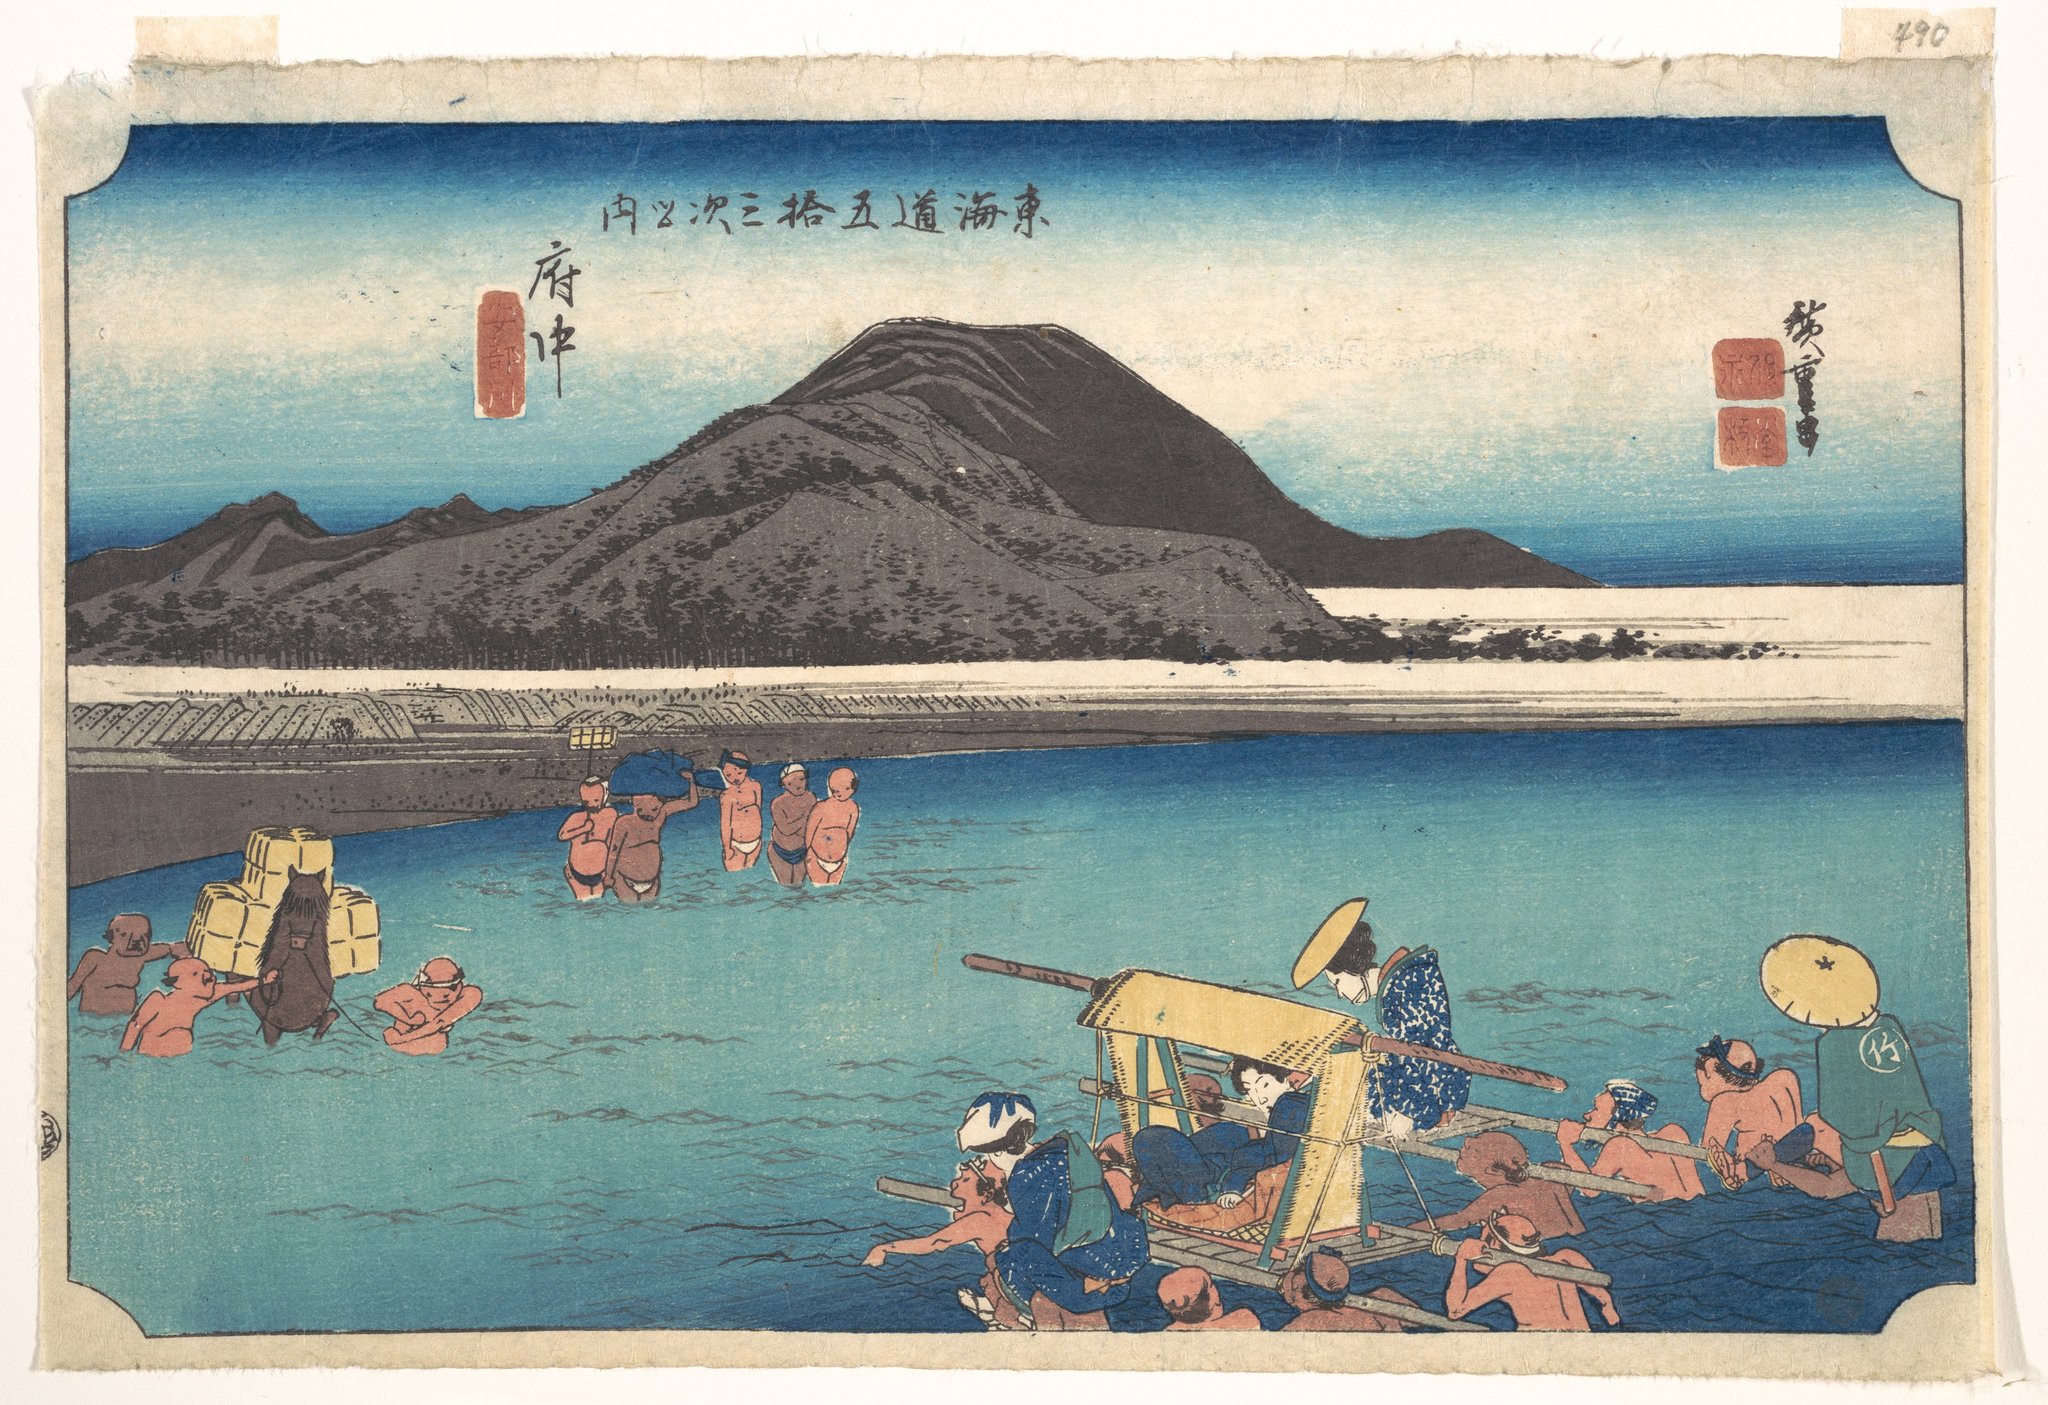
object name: print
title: Travellers Fording the Abe River at Fuchu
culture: japanese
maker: utagawa hiroshige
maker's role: artist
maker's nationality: japanese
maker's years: 1797-1858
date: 1833-1834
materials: ink, paper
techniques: woodblock print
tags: human figures,rivers,mountains